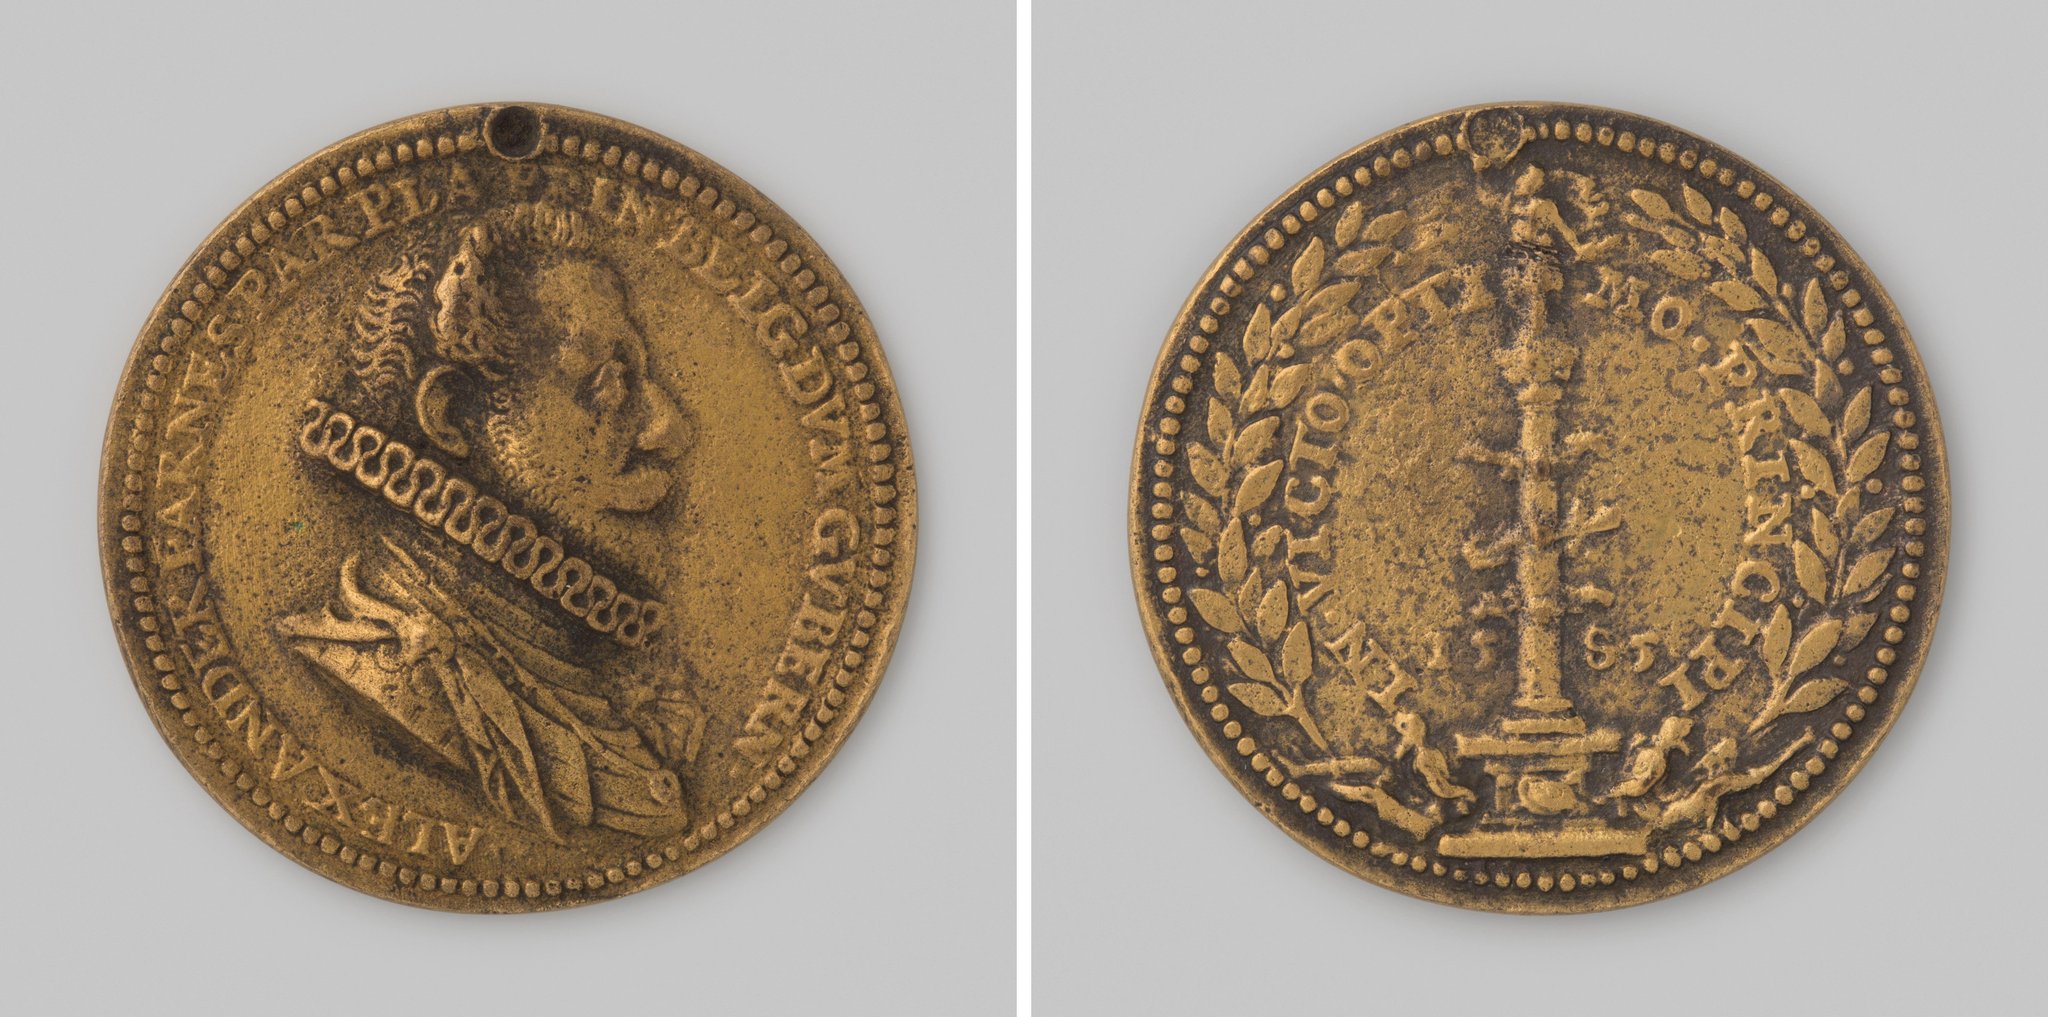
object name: history medal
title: Oprichting van een erezuil in Antwerpen voor Alexander Farnese Hertog van Parma 1585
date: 1585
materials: brass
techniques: casting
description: Messing penning, op de voorzijde het portret van Farnese naar rechts, met omschrift, op de keerzijde binnen een krans een standbeeld met een manspersoon, met omschrift.